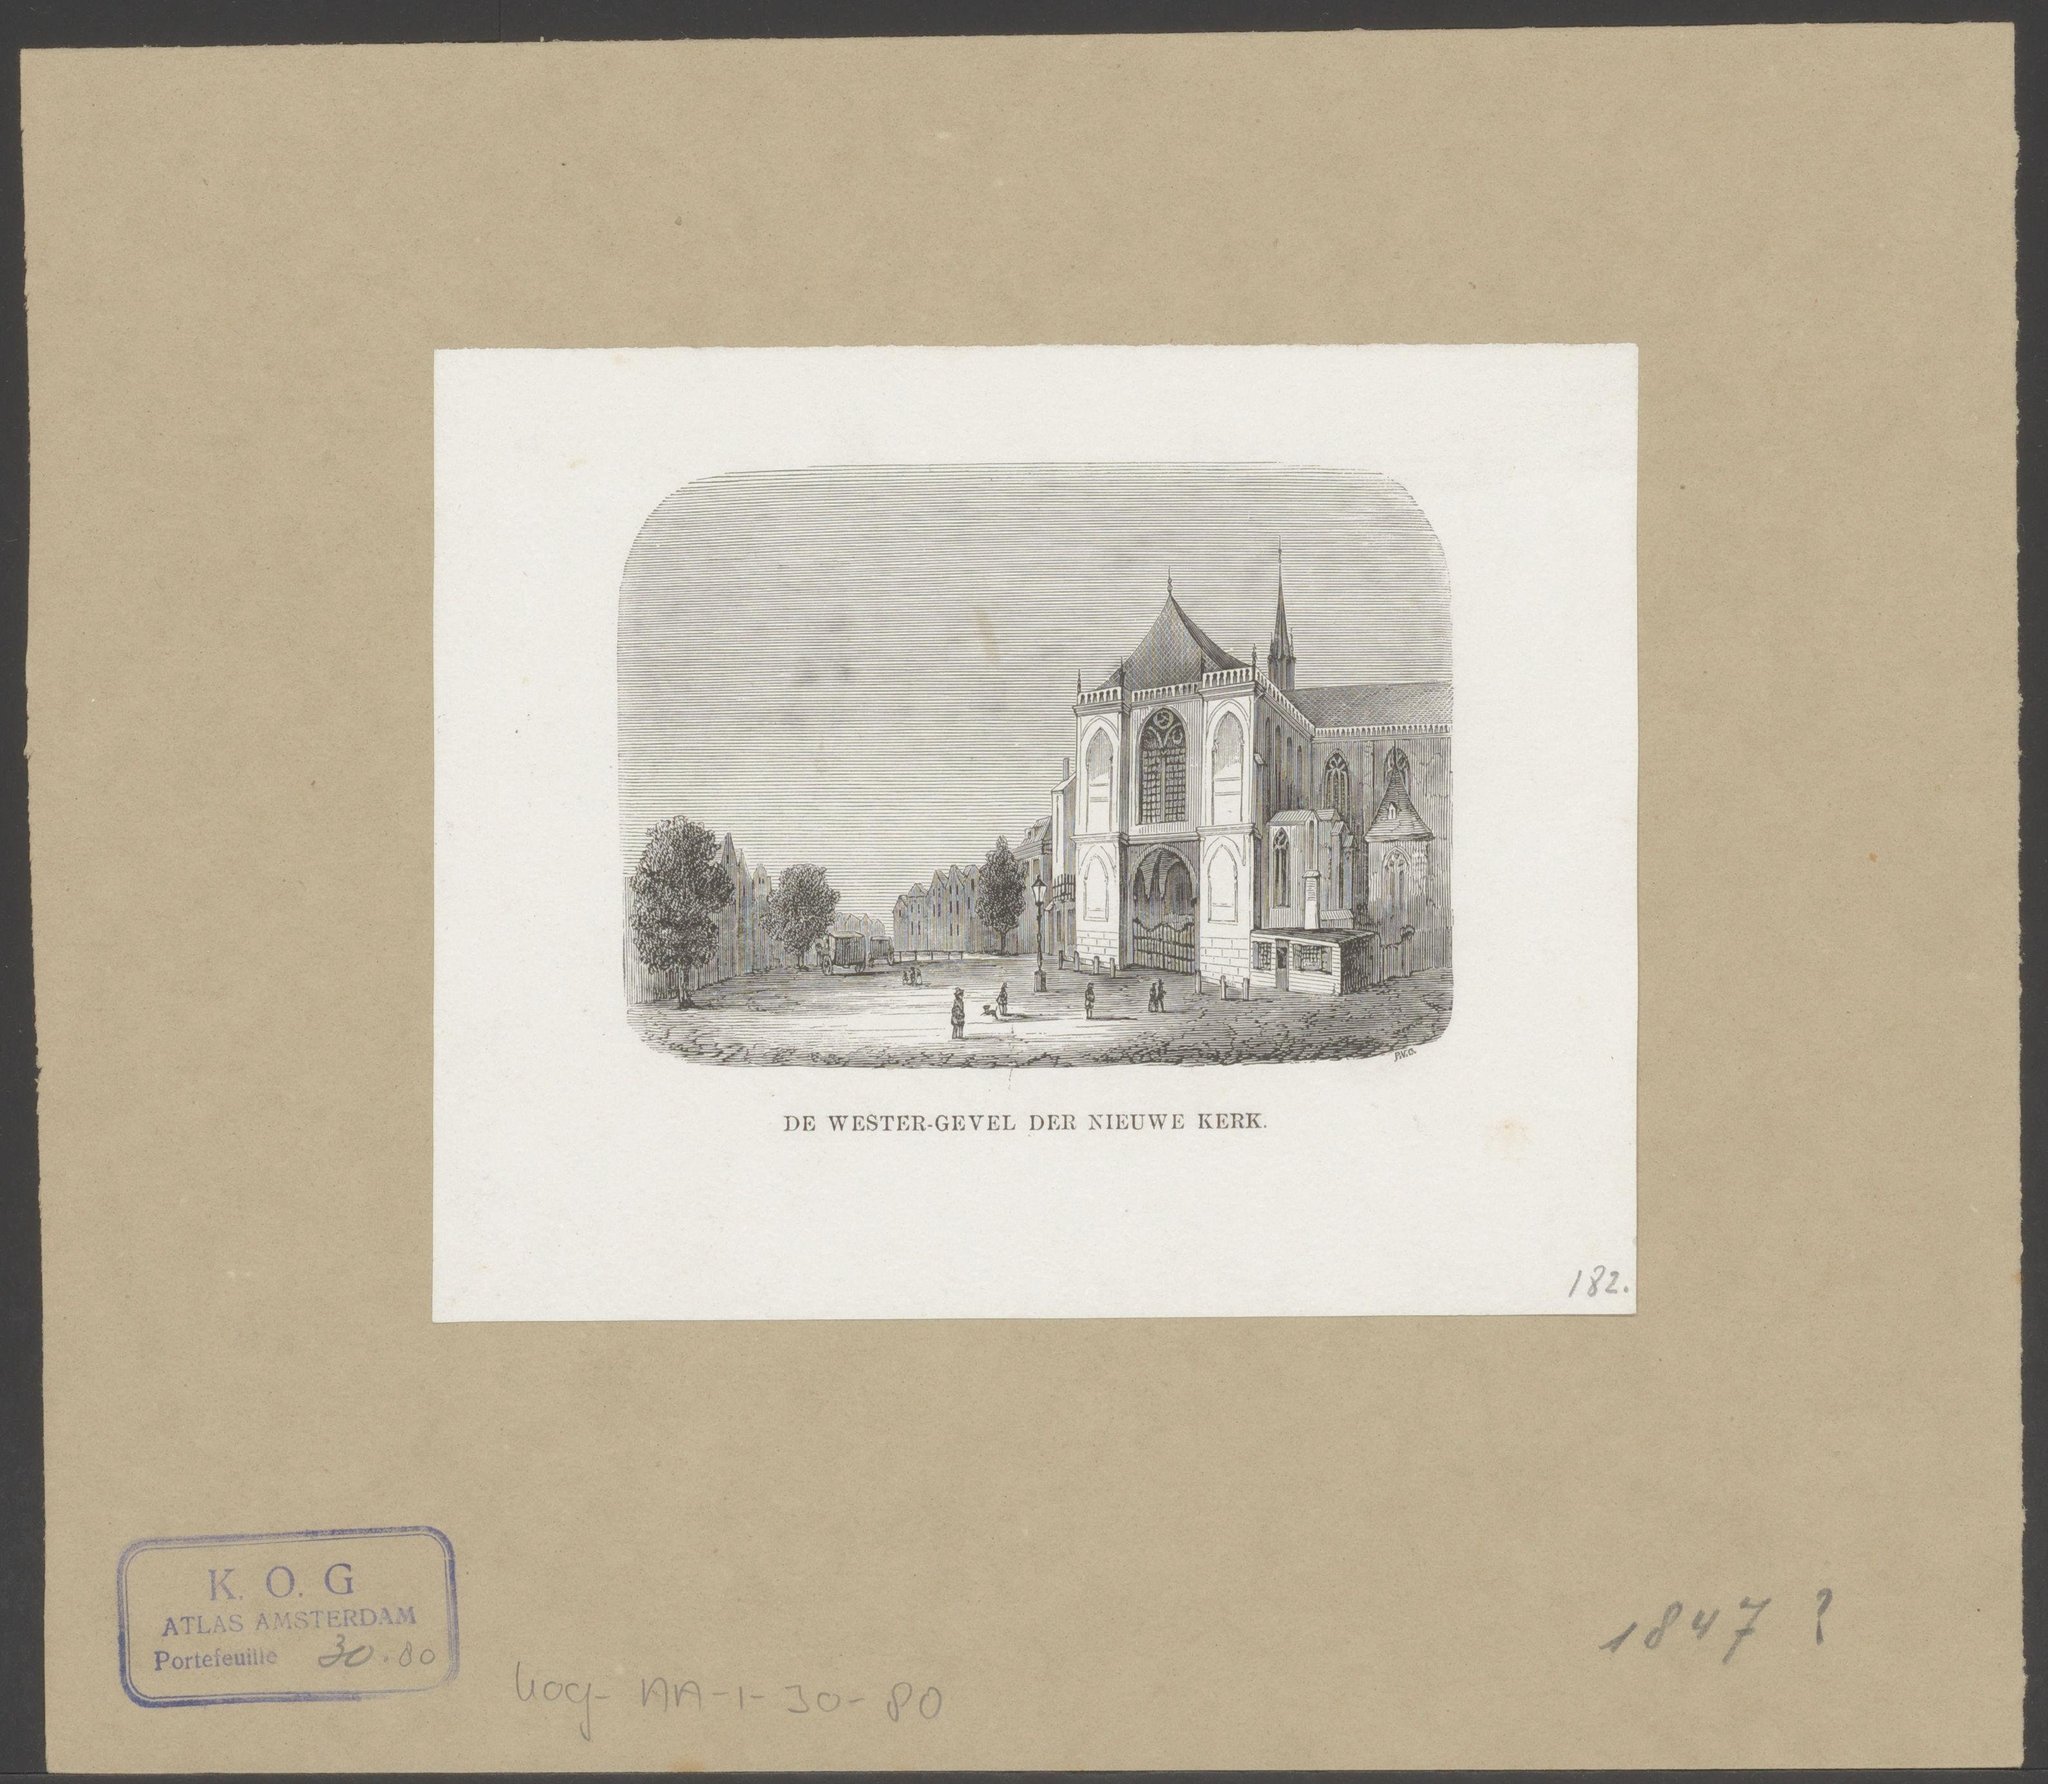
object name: print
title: Gezicht op de Nieuwe Kerk te Amsterdam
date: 1851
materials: paper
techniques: letterpress printing, engraving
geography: netherlands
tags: church (exterior), street (+ city(-scape) with figures, staffage)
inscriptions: collector's mark: Lugt 1641b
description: Prent uit: De Honigbij, of Bloemlezing op het gebied van kunst, wetenschap en smaak 10 (1851), 1851.